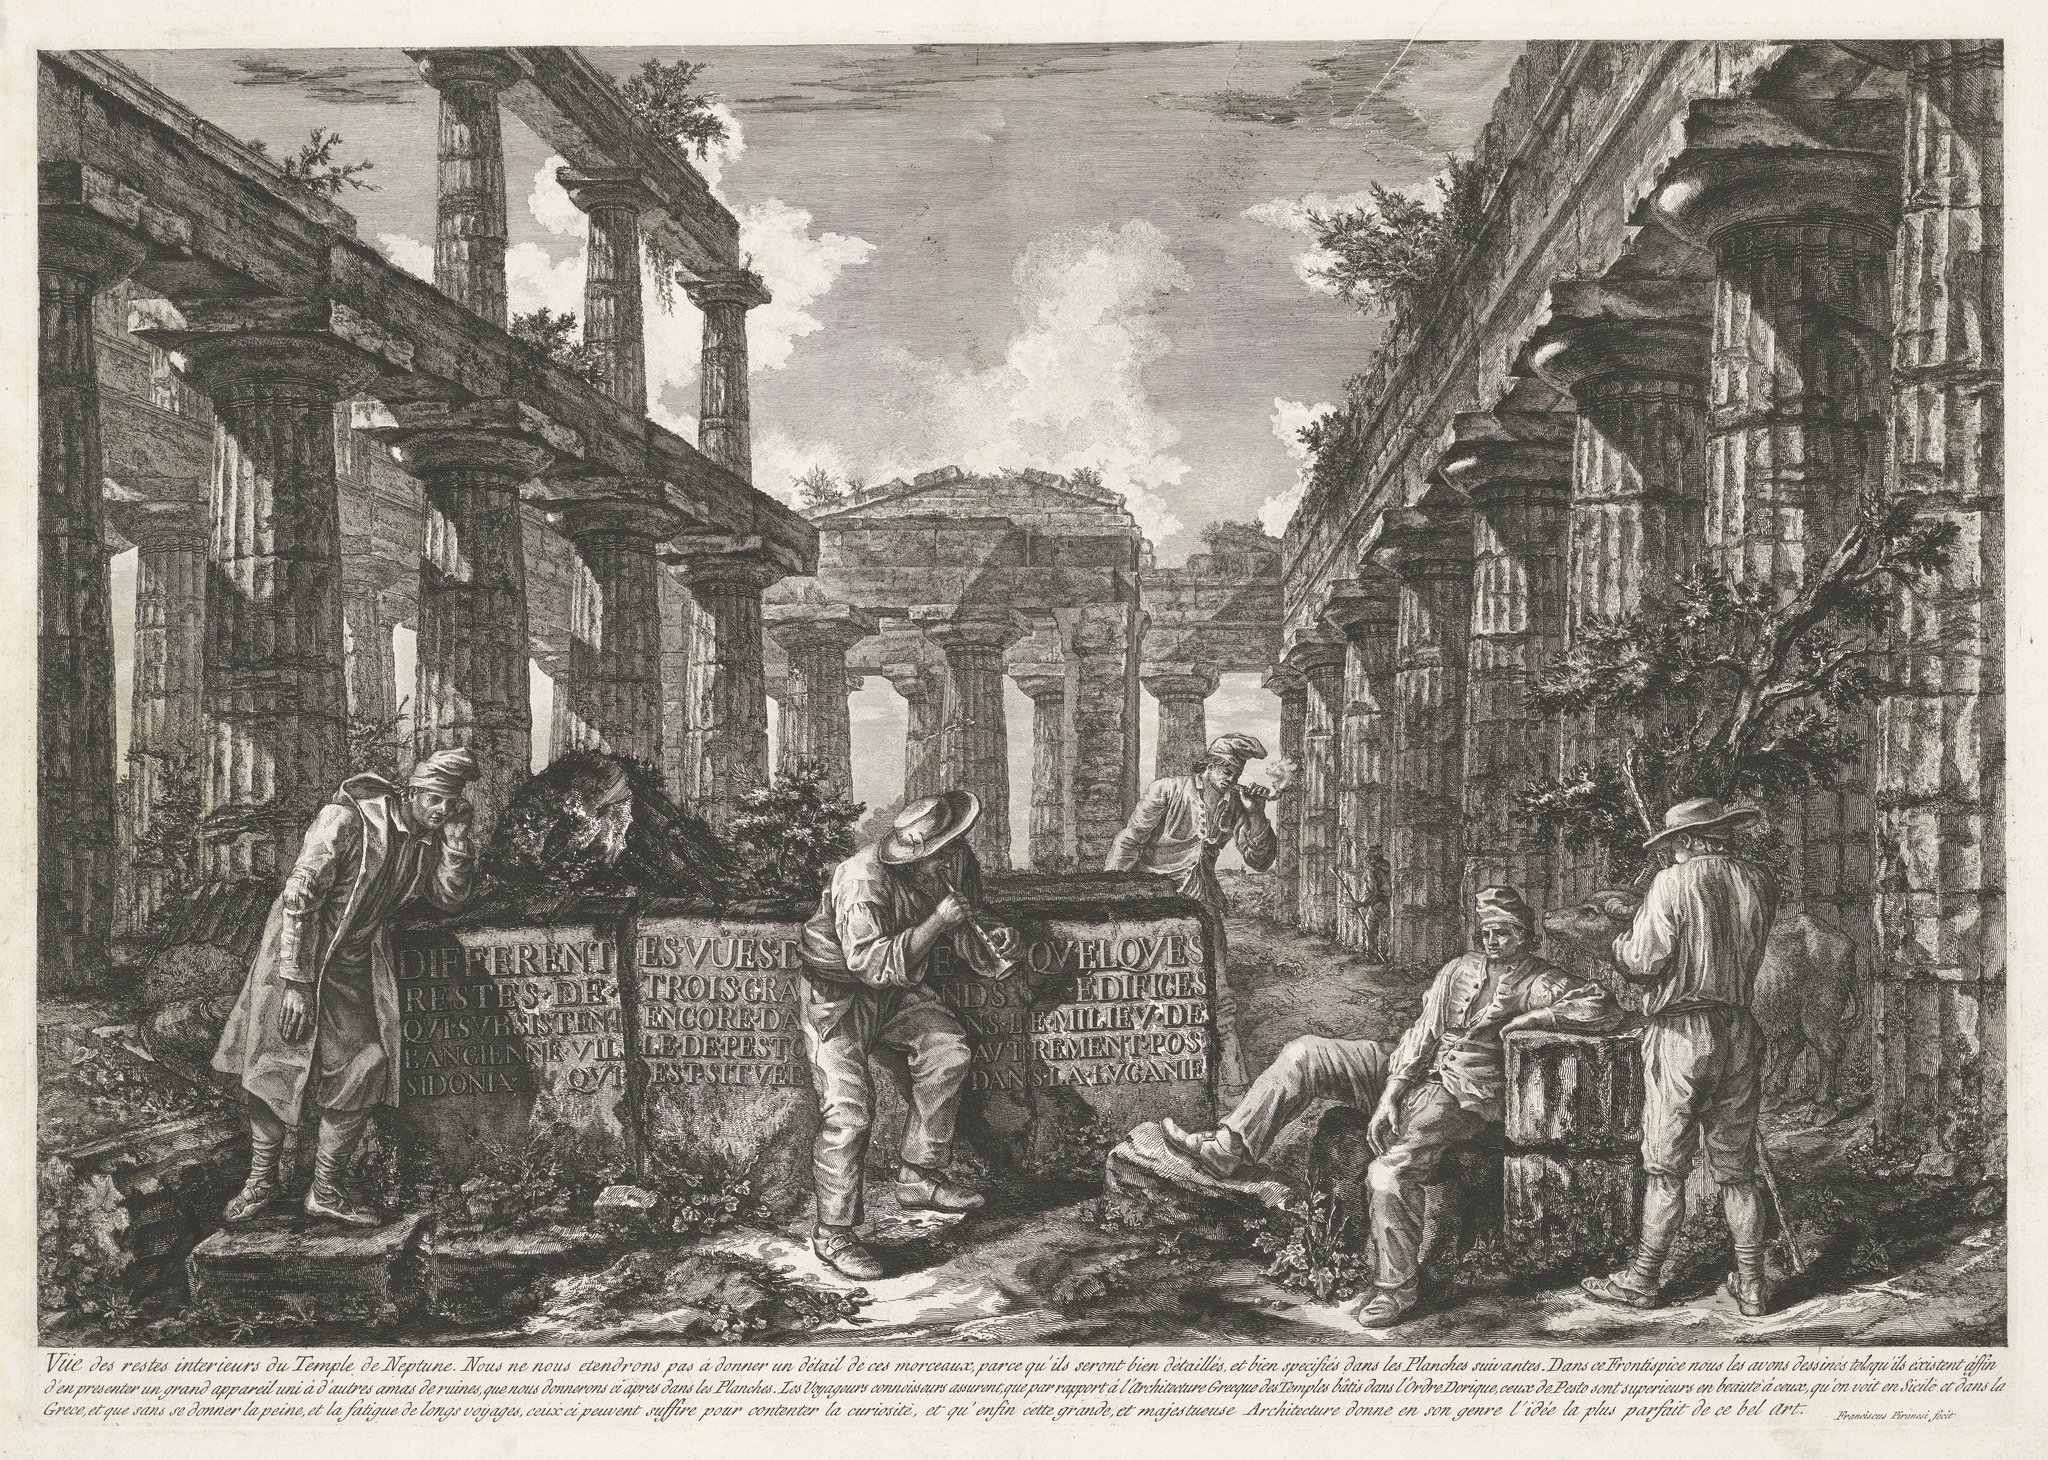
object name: titelprent, frontispice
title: Verschillende weergaven van de resten van drie grote gebouwen die nog steeds staan te Paestum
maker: francesco piranesi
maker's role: print maker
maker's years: 1758-1810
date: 1778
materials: paper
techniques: etching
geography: rome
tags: ruin of a building ~ architecture, landscape with ruins, temple, shrine ~ roman religion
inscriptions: collector's mark: Lugt 2228, collector's mark: Lugt 2760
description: Titelprent bij een reeks van 20 prenten met gezichten op tempels te Paestum. De gebouwen en de vegetatie op de prenten zijn uitgevoerd door Giovanni Battista Piranesi. De figuren zijn mogelijk uitgevoerd door zijn zoon Francesco.